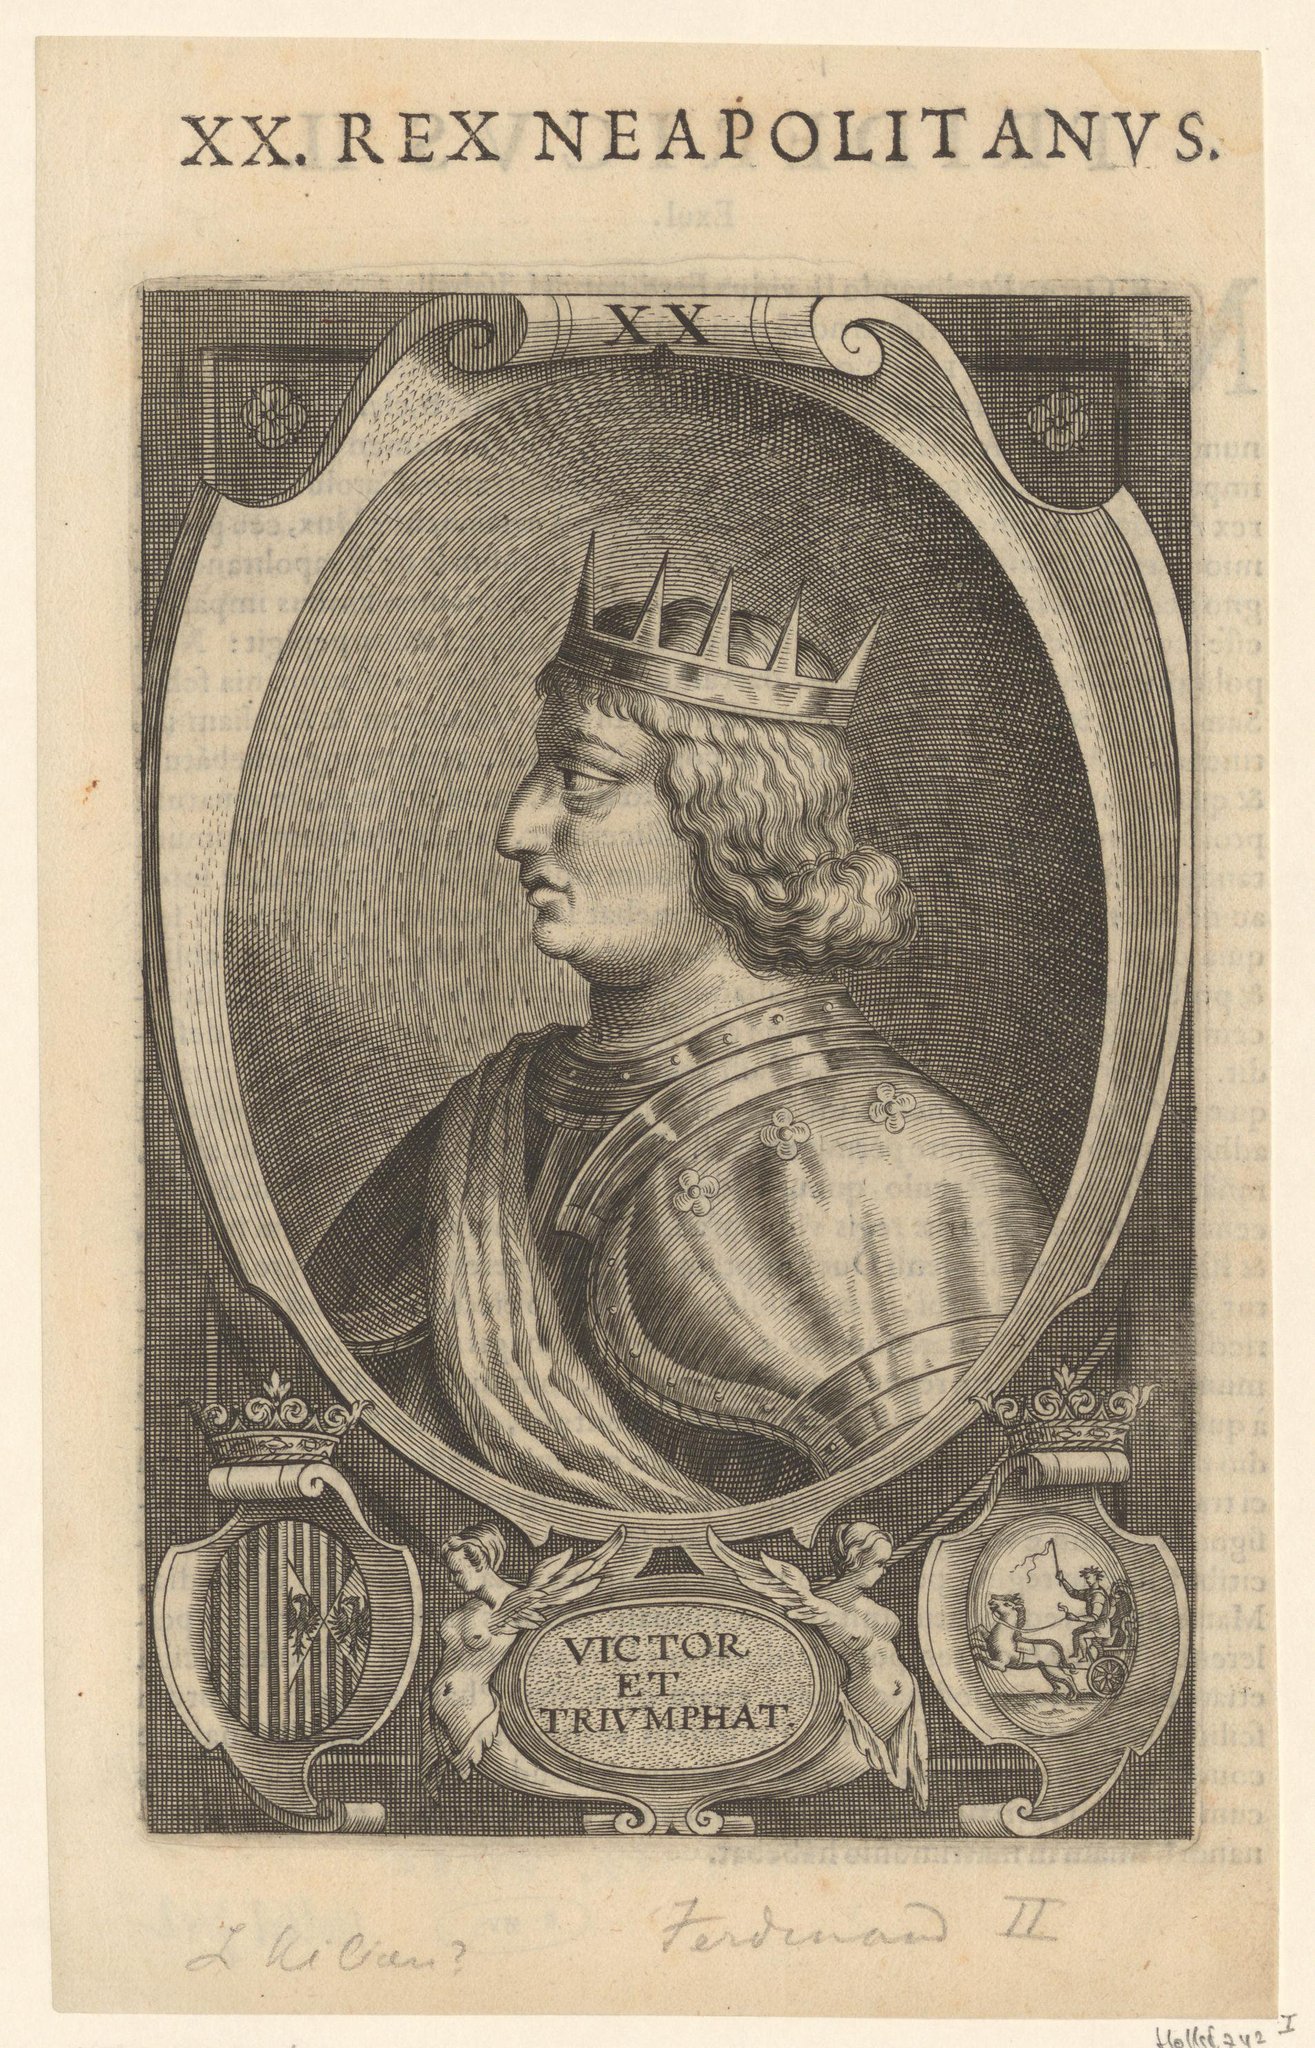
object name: print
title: Portret van Ferdinand II, koning van Napels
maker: lucas kilian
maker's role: draughtsman, print maker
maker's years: 1579-1637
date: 1589-1624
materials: paper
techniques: engraving, etching, letterpress printing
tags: historical persons, king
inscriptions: collector's mark: Lugt 2228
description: Deze prent is gebruikt in: Mazzella, Scipione, Kilian, Lucas en Custos, Dominicus. Der Neapolitanische Koenige Leben und Bildnisse (...). Augsburg: Lucas Kilian, 1624.